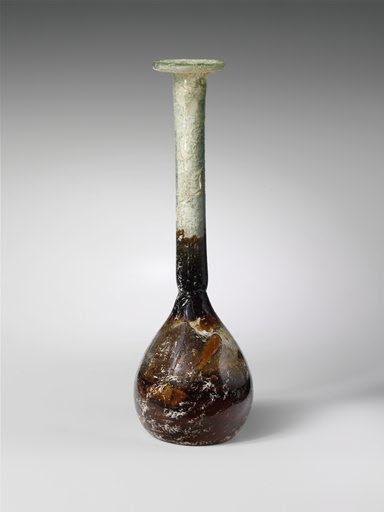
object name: perfume bottle with content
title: Glass perfume bottle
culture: roman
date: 101-300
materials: glass